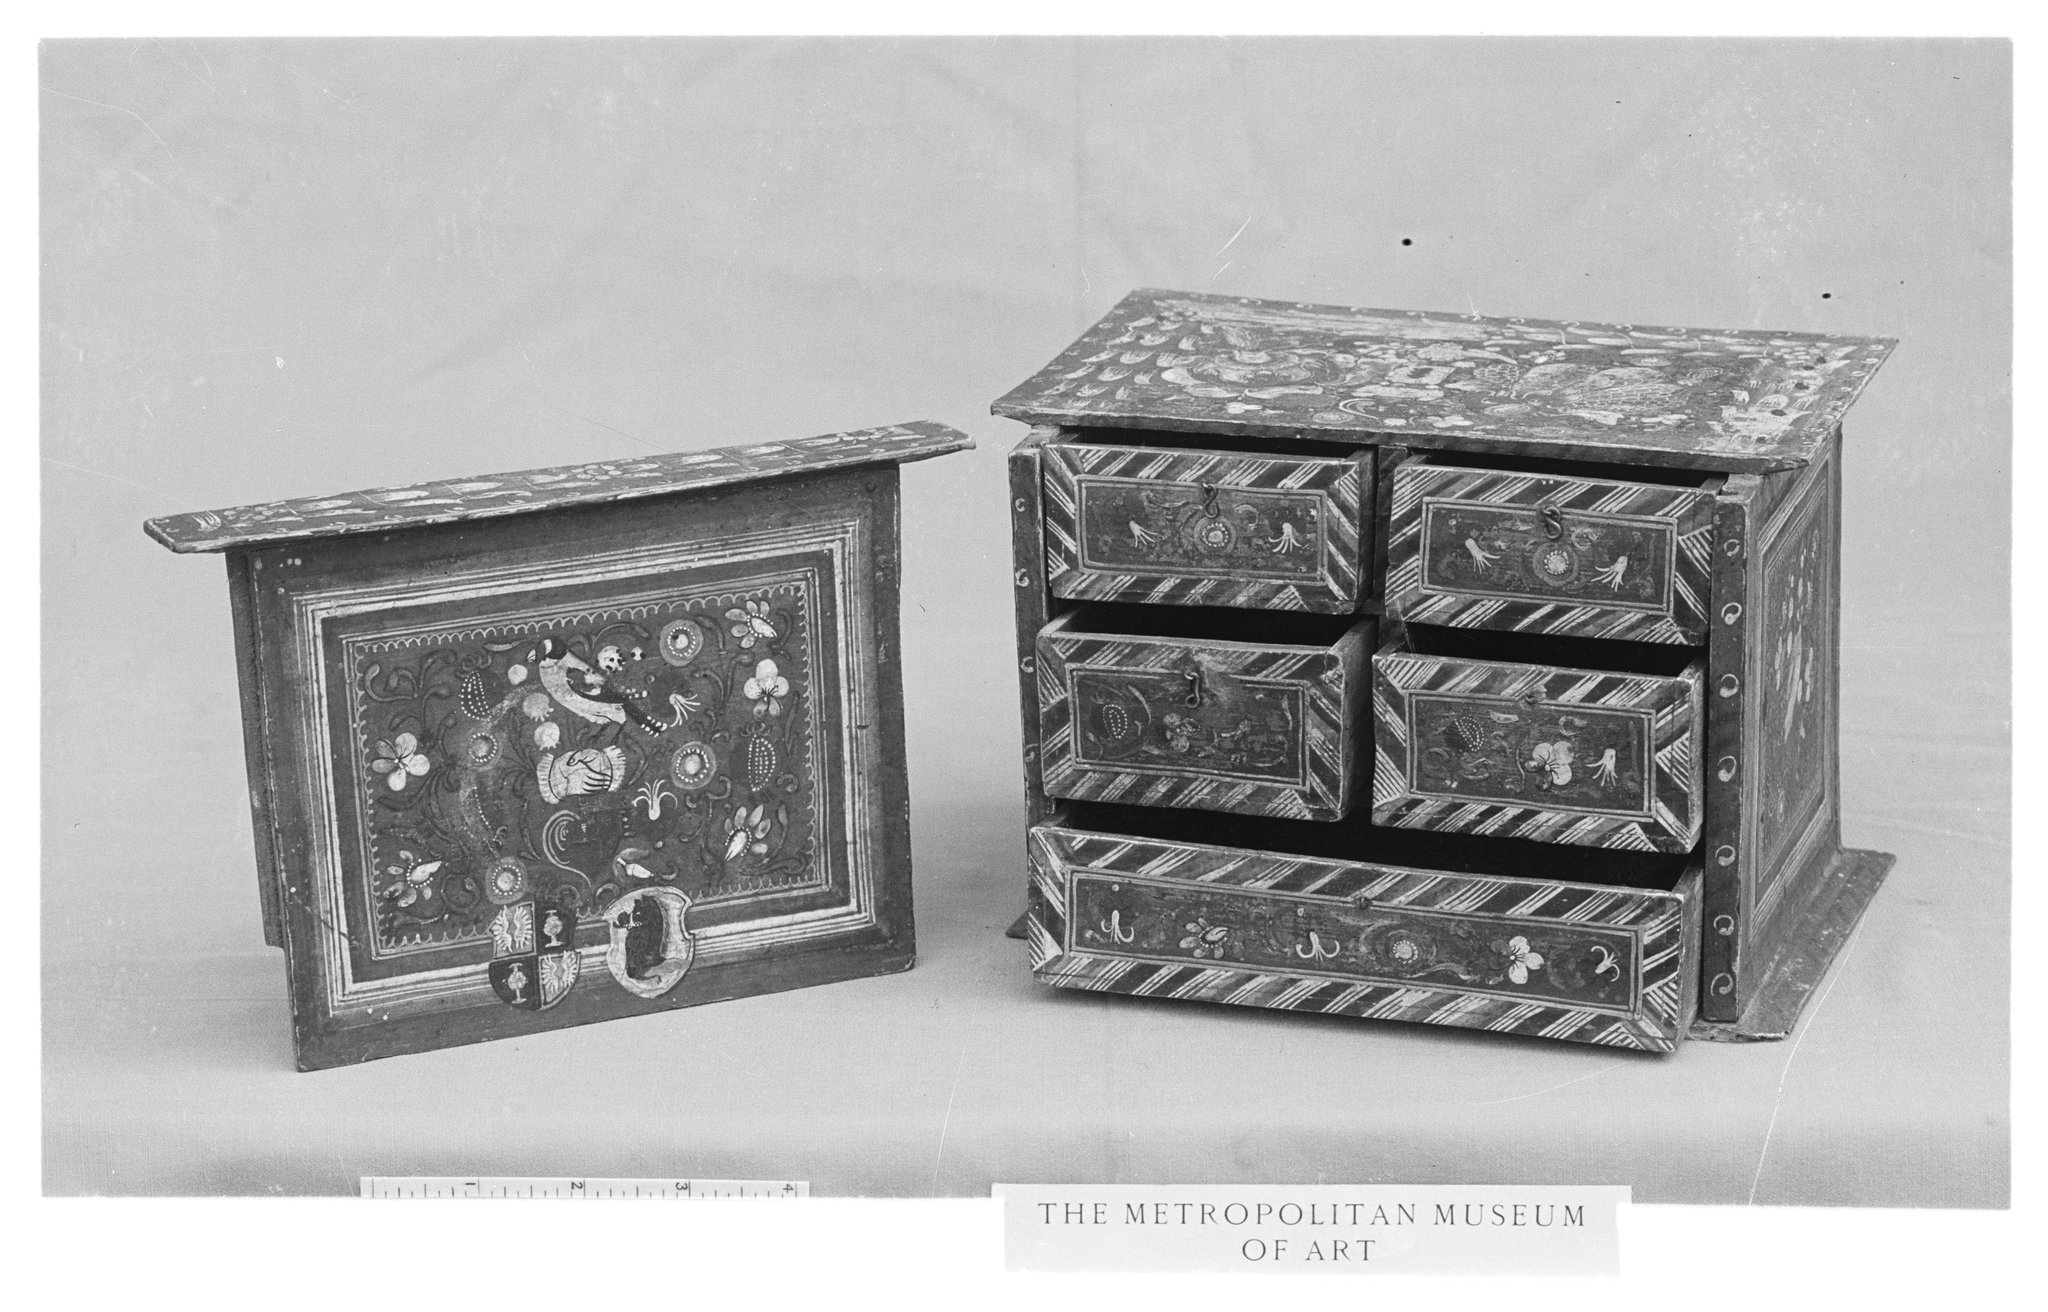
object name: box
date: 1701-1800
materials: wood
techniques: painting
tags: birds,flowers,coat of arms